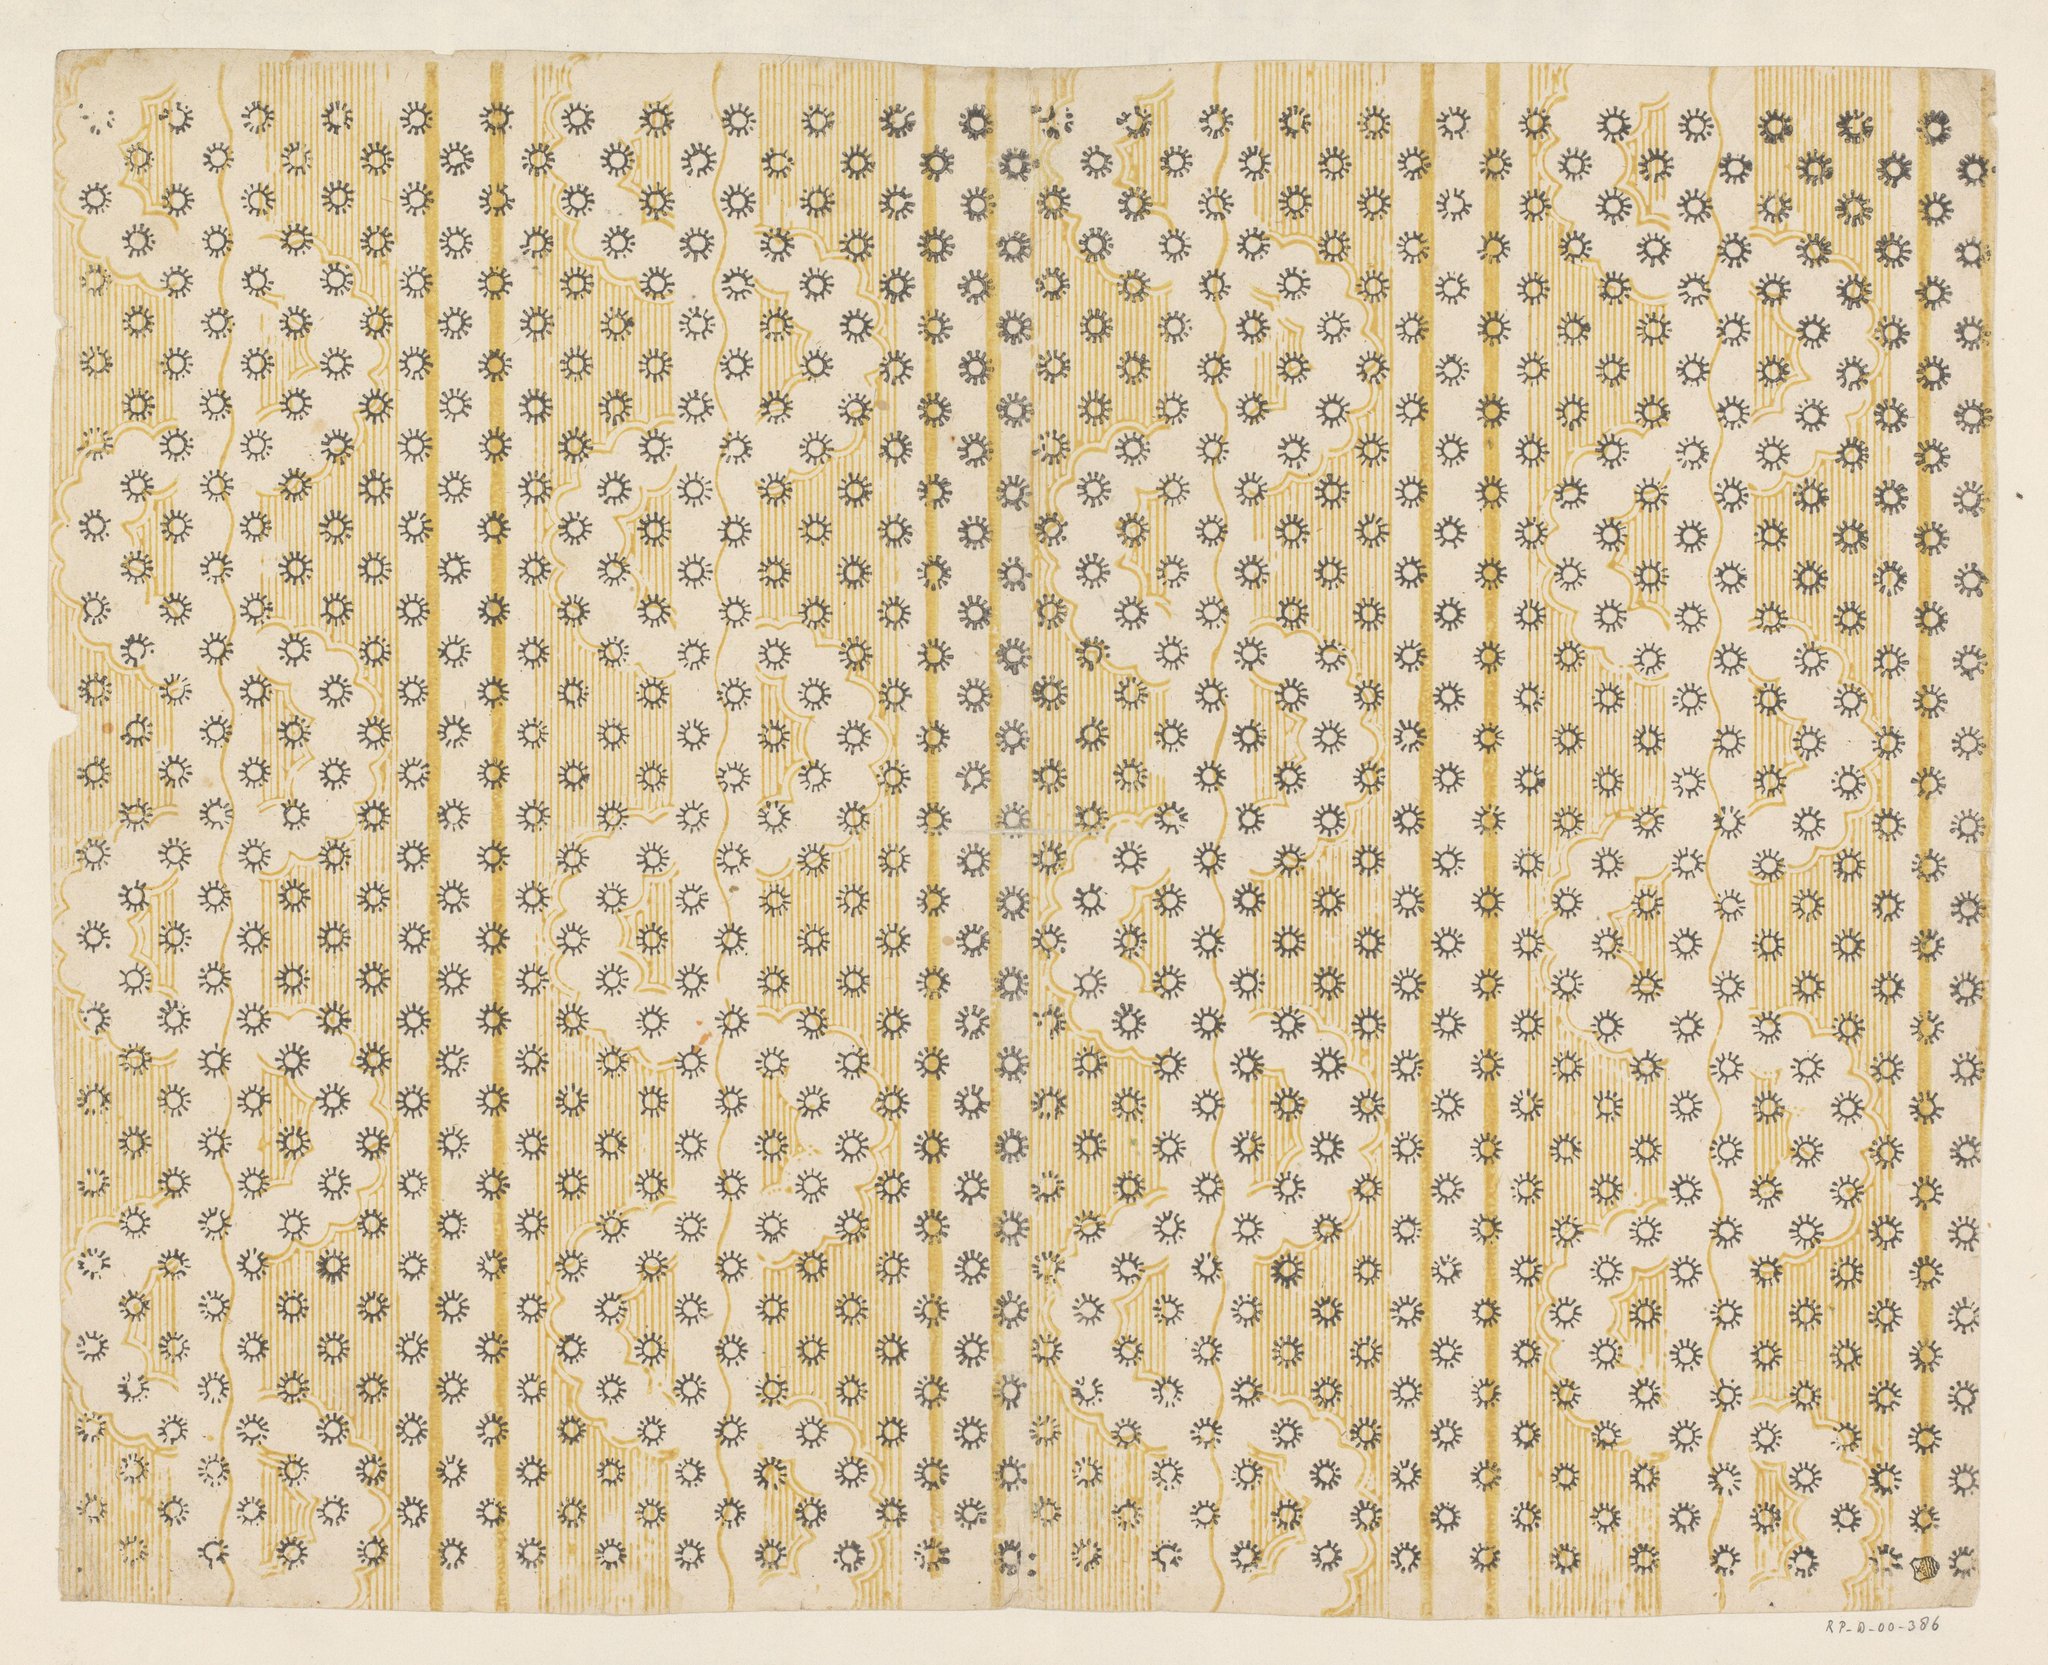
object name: printed paper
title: Blad met fond in banenpatroon van strepen en slingerende wolk met strooipatroon van zonmotief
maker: Anonymous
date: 1700-1850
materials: paper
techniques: printing block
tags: ornament derived from objects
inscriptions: collector's mark: Lugt 2760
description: Blad met fond in banenpatroon van strepen en slingerende wolk met daaroverheen strooipatroon van zonnetjes.